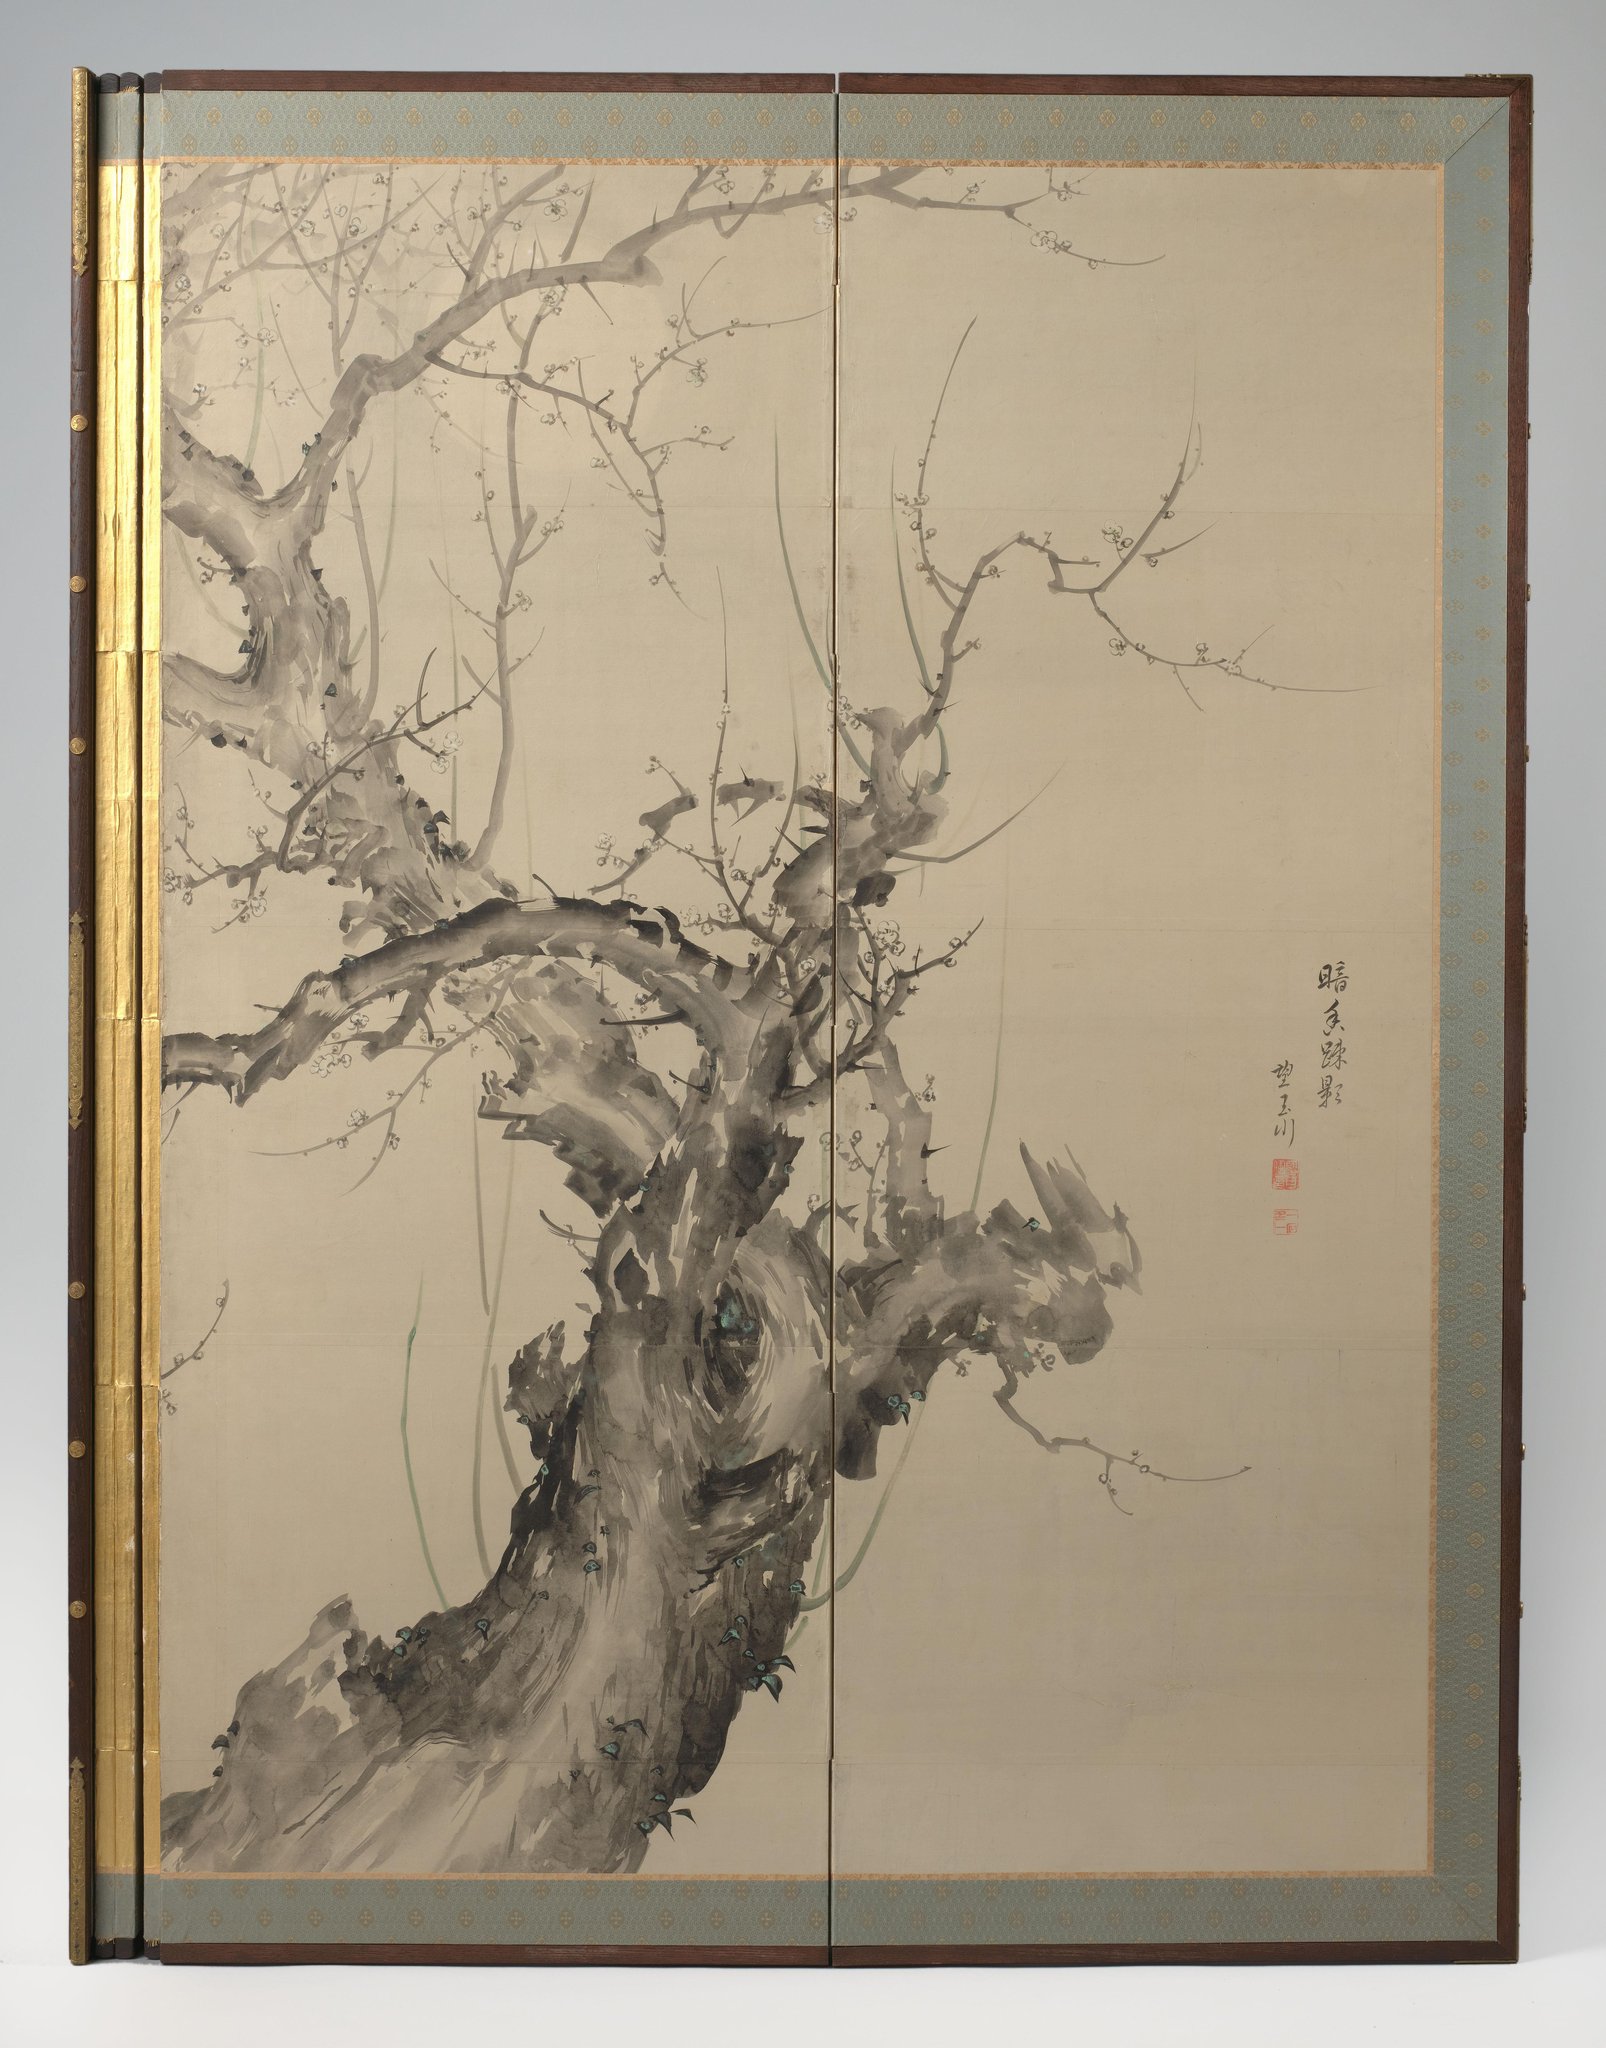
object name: vouwscherm, kamerscherm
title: Three Friends of Winter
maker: mochizuki gyokusen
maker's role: painter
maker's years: 1794-1852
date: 1800-1850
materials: ink, paper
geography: japan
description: The ‘three friends of winter’ comprise bamboo, pine and plum. The first two remain green in winter, while the plum blossoms herald spring. The pine tree makes it clear that the worst of the cold is over: snow is slipping off a branch. Gyokusen cleverly used the white of the paper to suggest snow.